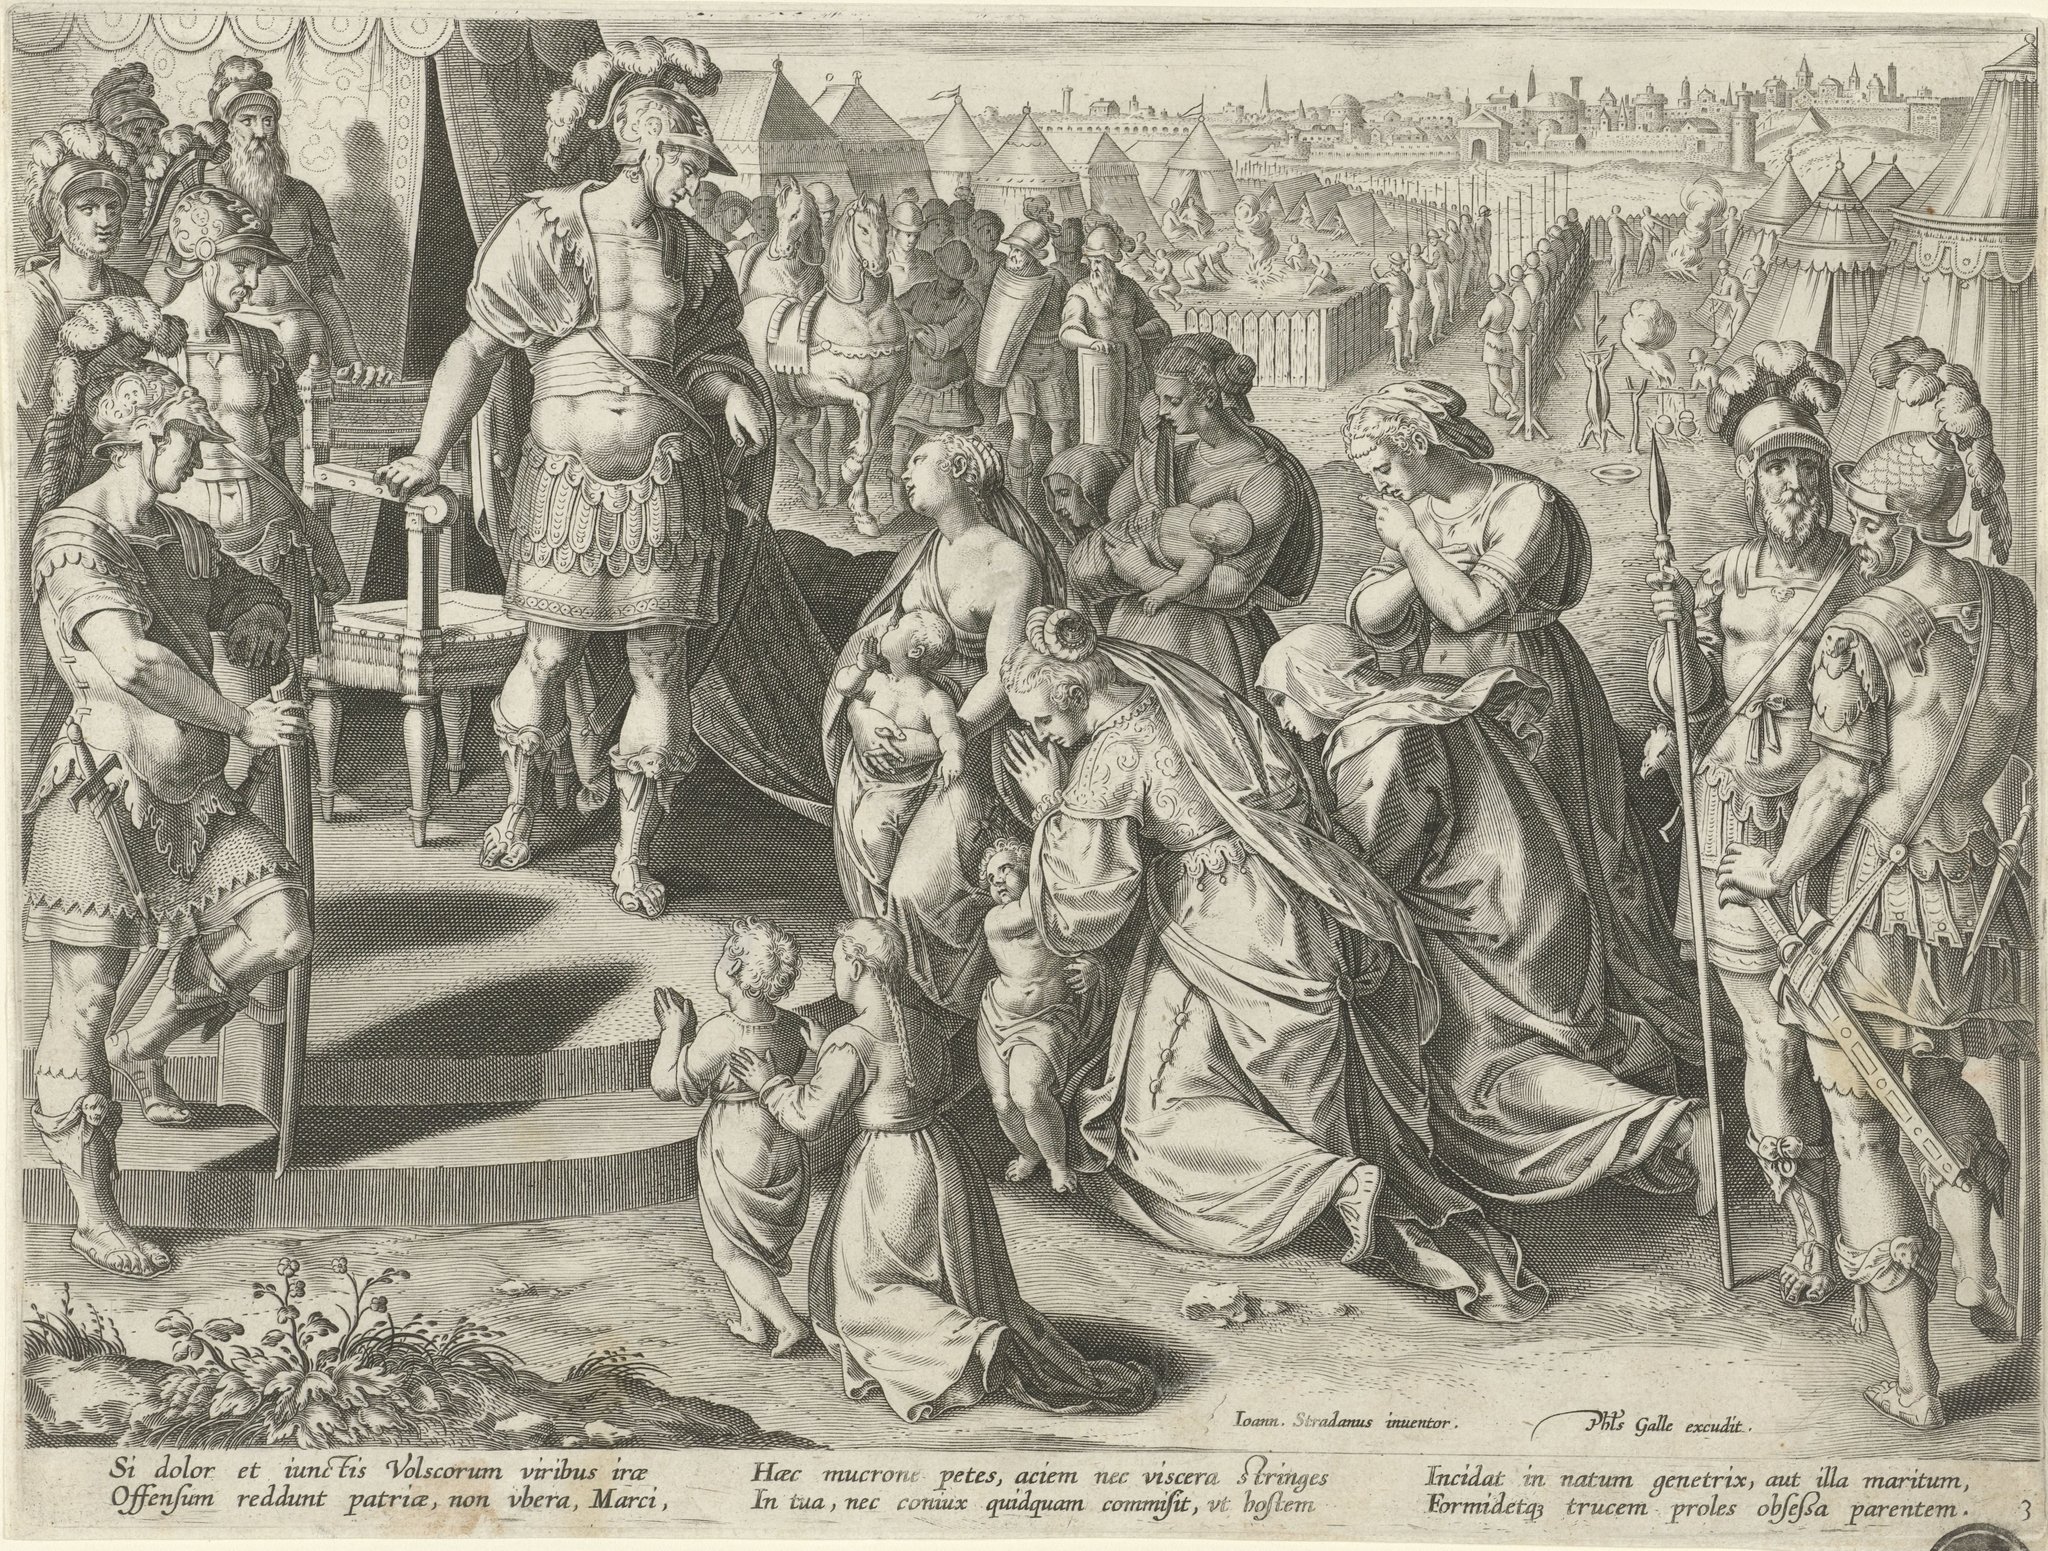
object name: print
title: Veturia aan de voeten van Coriolanus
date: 1593-1597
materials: paper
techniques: engraving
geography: antwerp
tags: coriolanus (c. or cn. marcius) is met by his wife volumnia (alternatively called vergilia) with their two small sons, and his mother veturia (alternatively called volumnia); they entreat him not to fight any more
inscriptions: collector's mark: Lugt 2228, collector's mark: Lugt 2760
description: Gaius Marcius Coriolanus staat met een enorme troepenmacht voor de muren van Rome. Zijn moeder Veturia en zijn vrouw Virgilia (Volumnia) en zijn kinderen smeken hem op hun knieën Rome niet aan te vallen. Coriolanus wordt door hun smeekbedes overtuigd. De prent heeft een Latijns onderschrift en maakt deel uit van een zesdelige serie over beroemde Romeinse vrouwen.